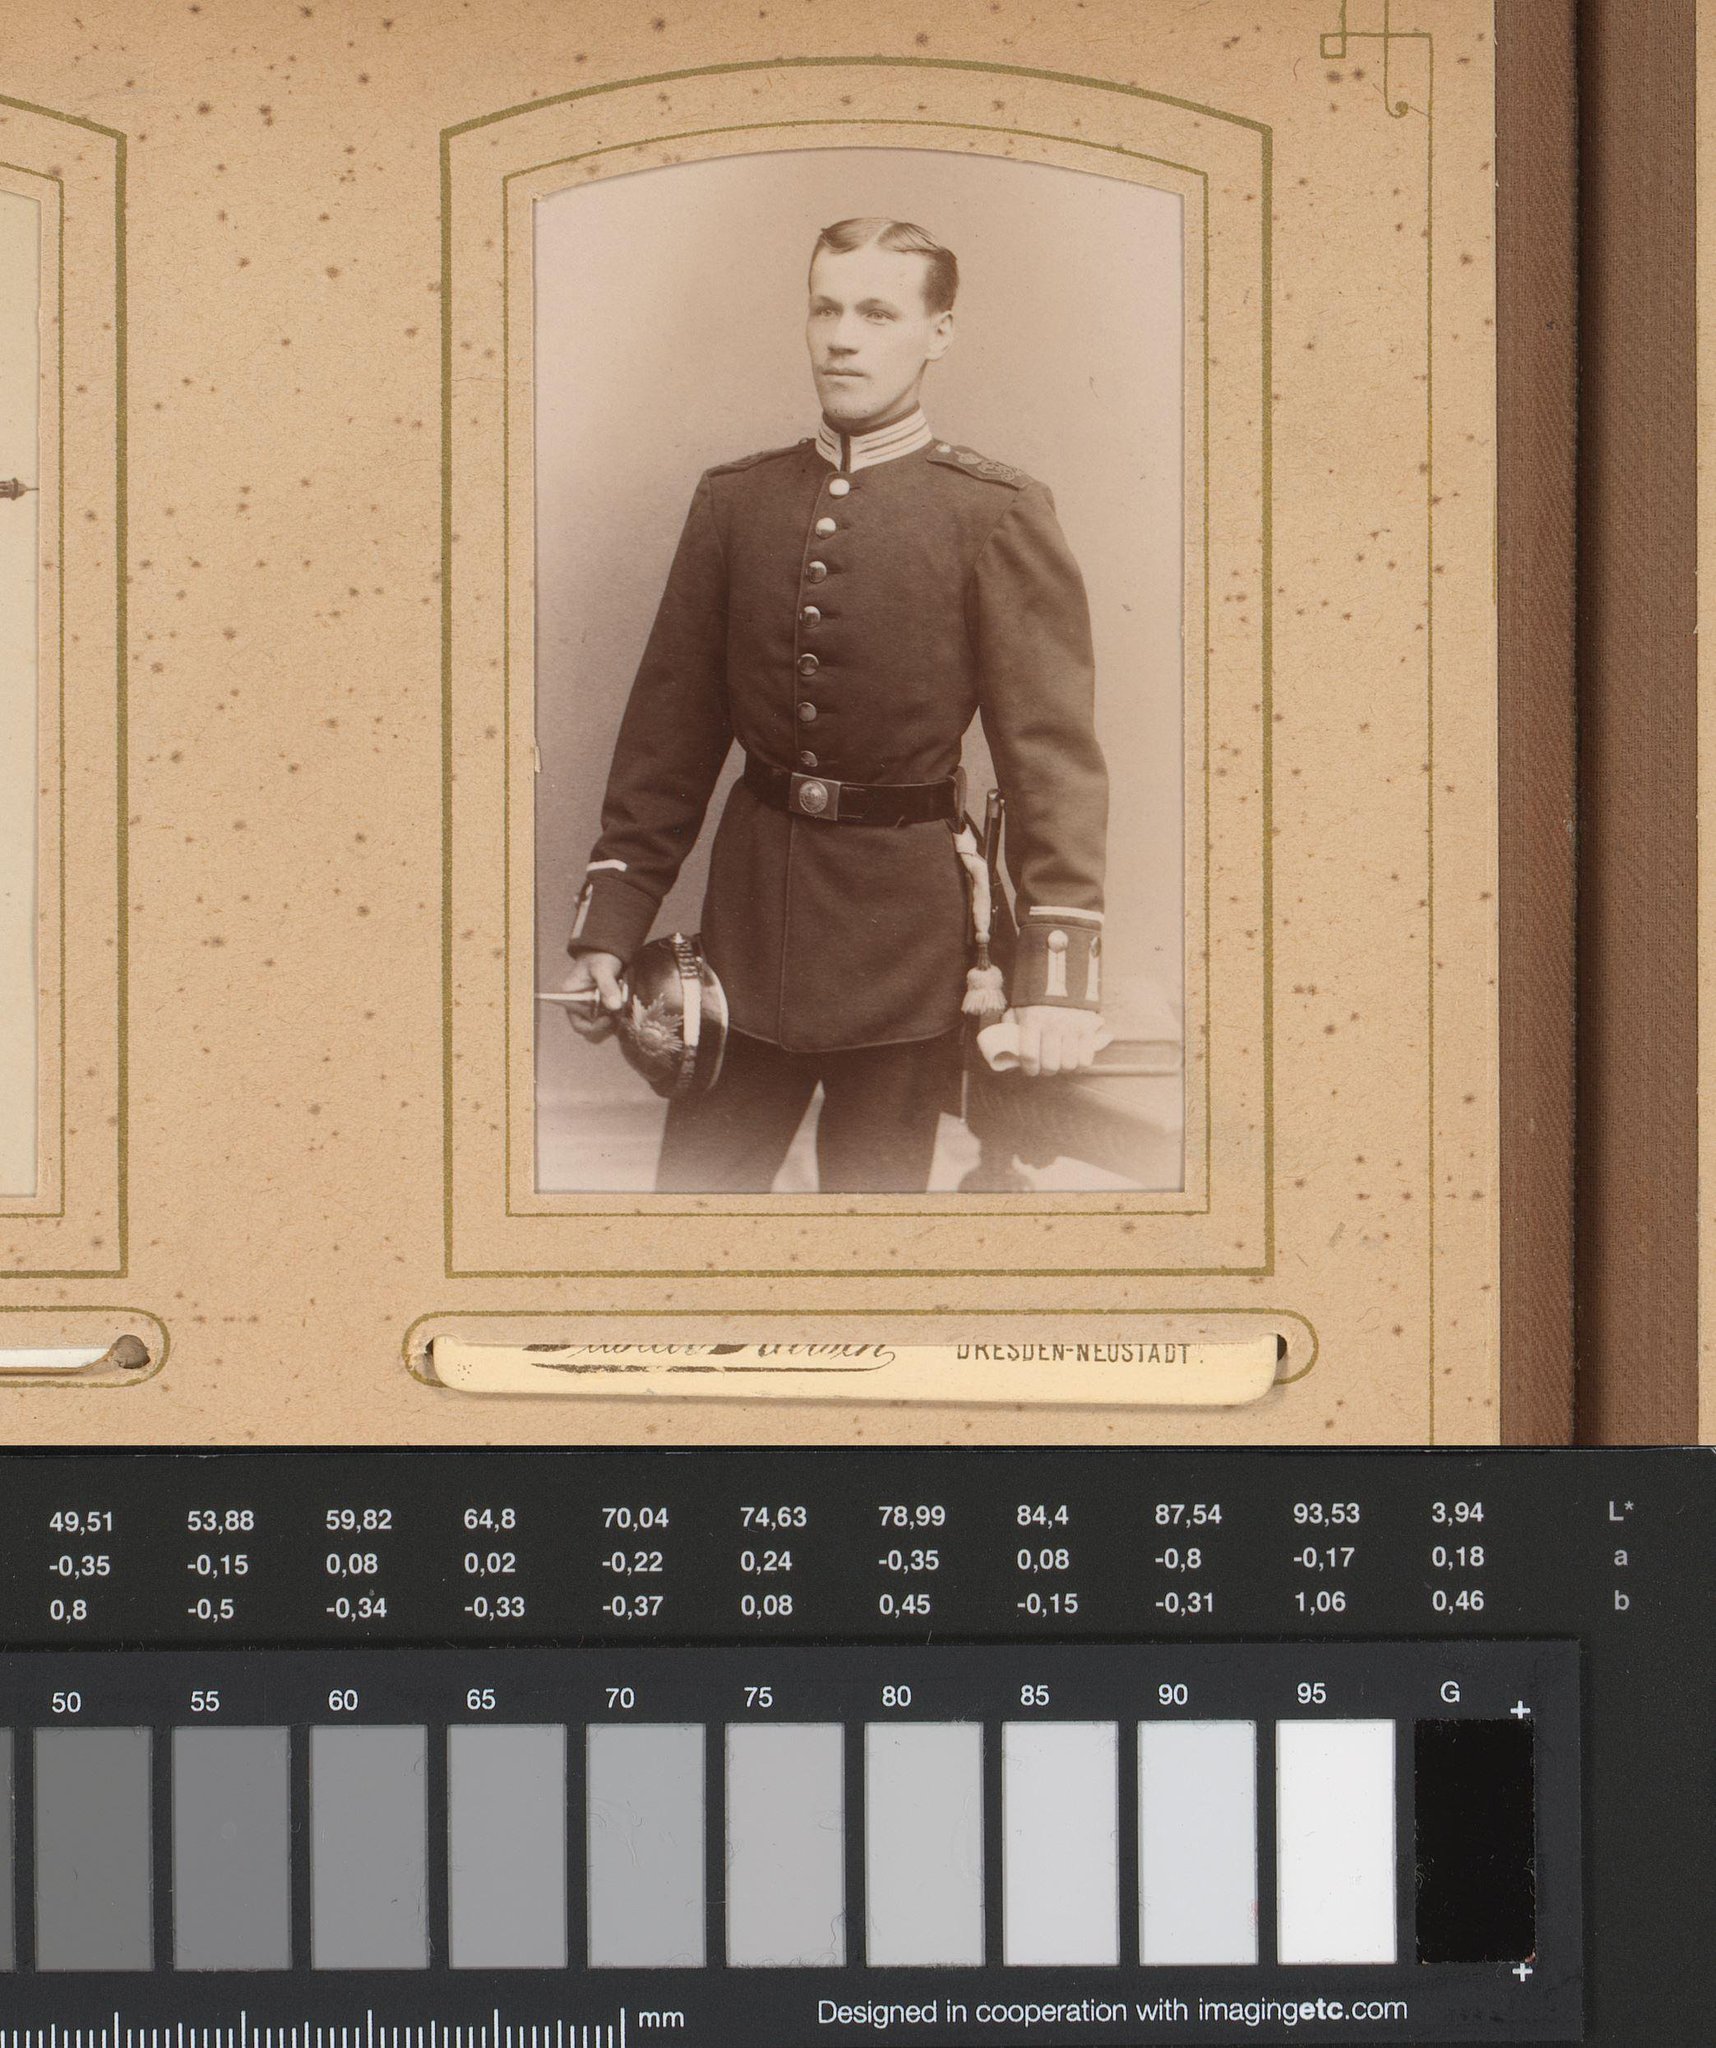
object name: photograph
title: Portret van een staande man in uniform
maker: gustav karsch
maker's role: fotograaf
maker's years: 1848-1903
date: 1860-1900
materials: cardboard, photographic support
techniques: albumen print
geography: dresden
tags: historical persons, standing figure - aa - female human figure, (military) uniforms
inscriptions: inscription: ‘Photogr. Atelier/ Gustav Karsch/ DRESDEN-N./ Gr. Meissenerstrasse/ No 17.’